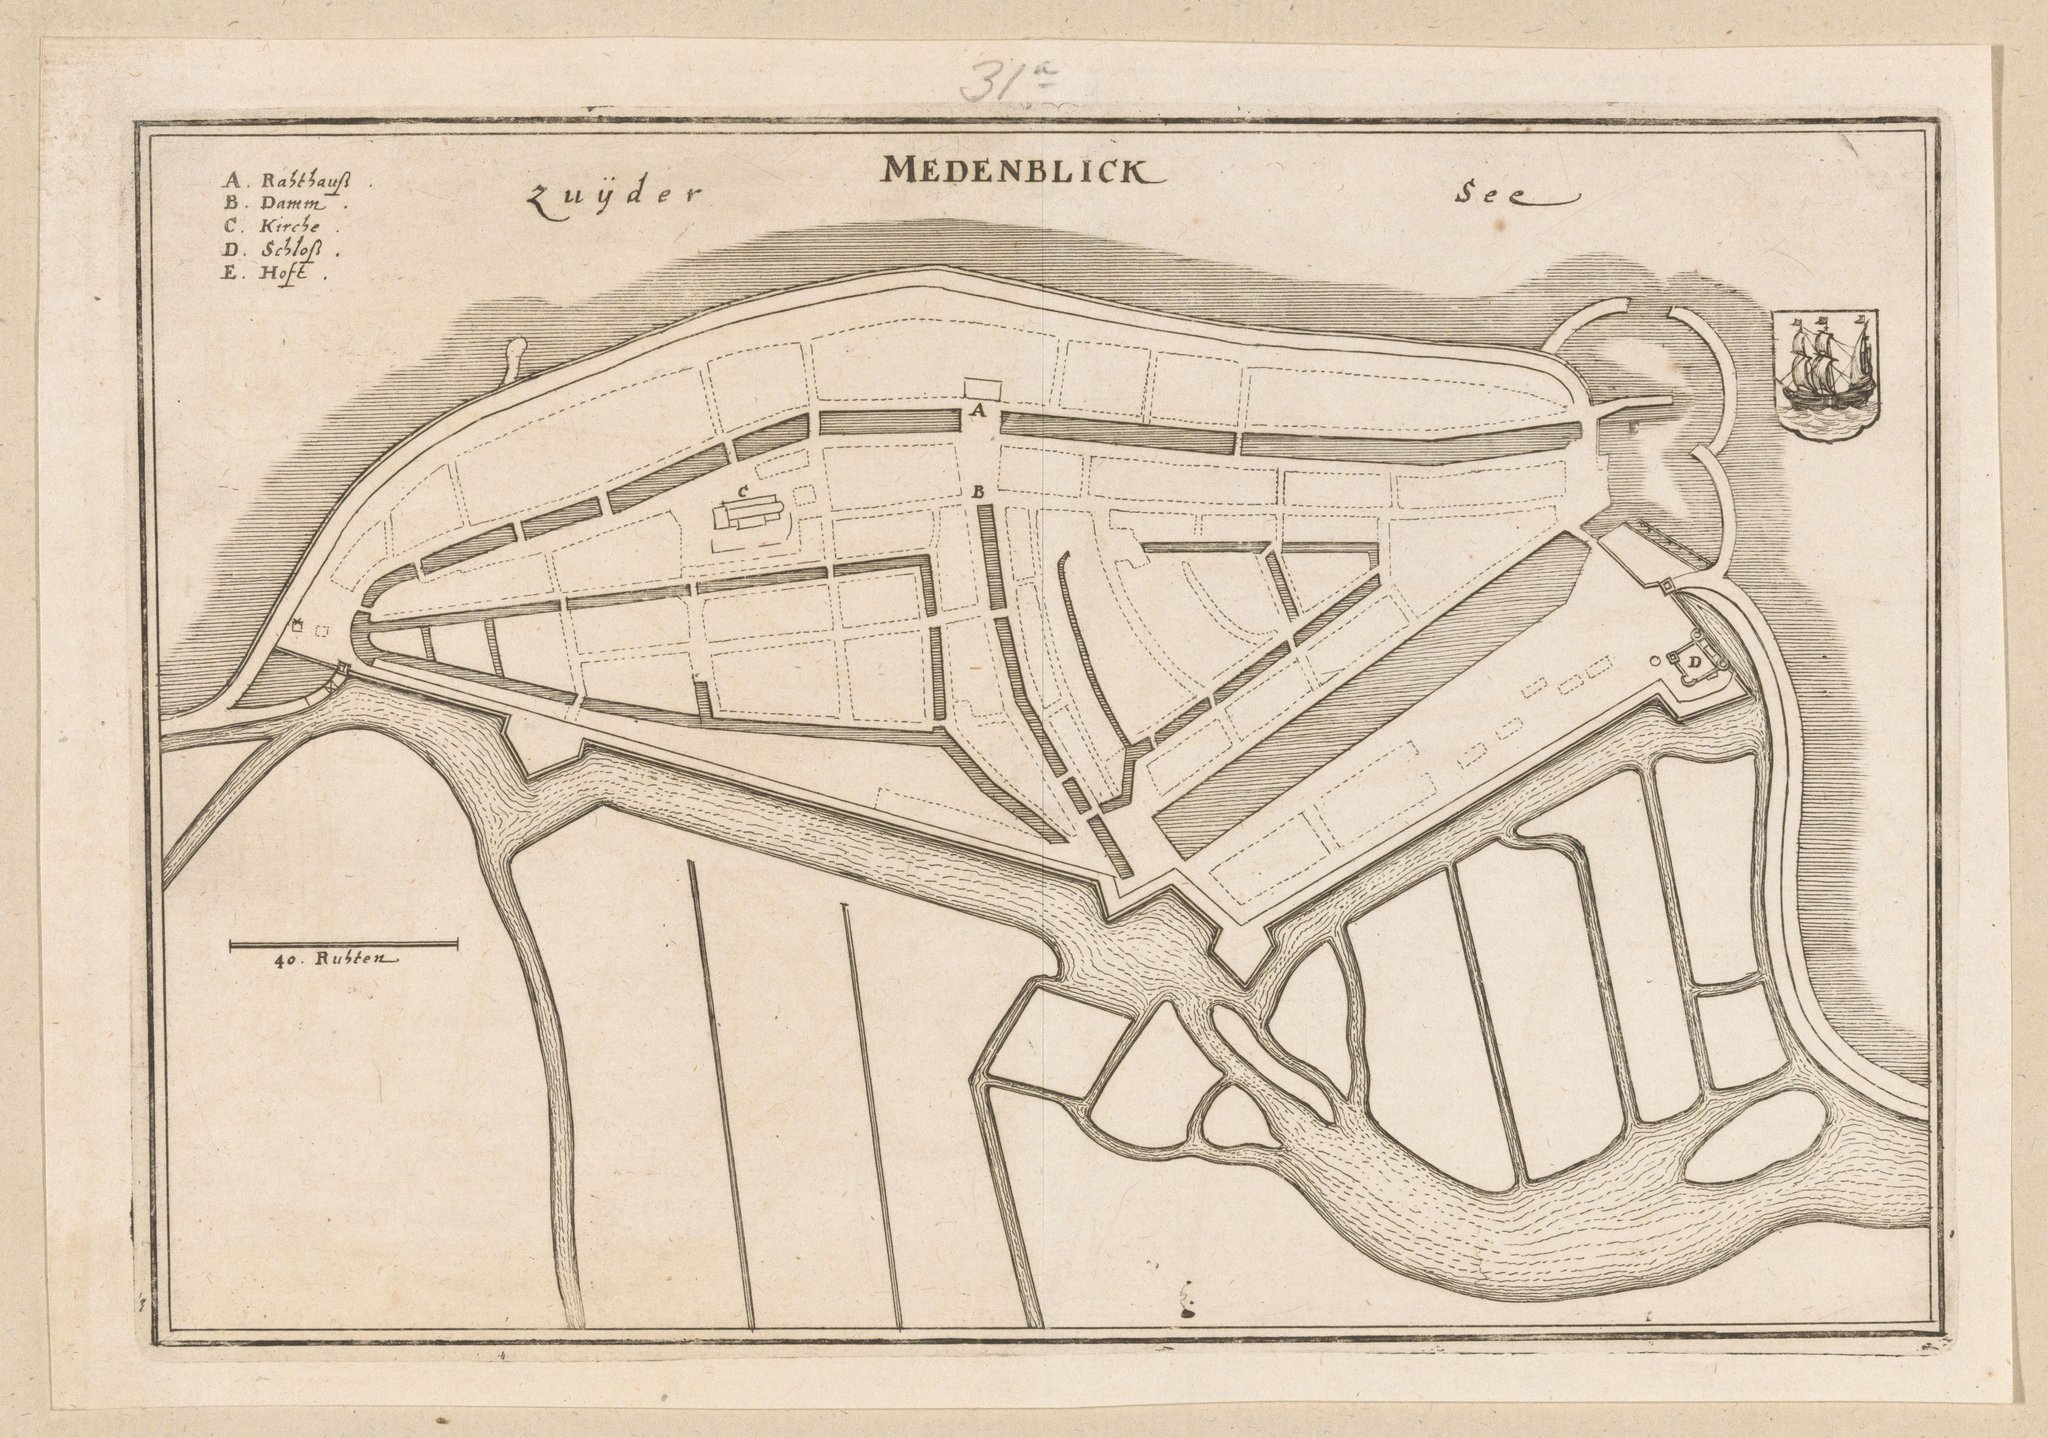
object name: print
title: Medenblick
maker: caspar merian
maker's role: print maker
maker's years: 1627-1689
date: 1654-1700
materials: paper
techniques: engraving, etching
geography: frankfurt am main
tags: coat of arms (as symbol of the state, etc.) (+ city; municipal), fortified city, maps of cities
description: Prent gebruikt in: Zeiller, Martin. M.Z. Topographia Circuli Burgundici Oder Beschreibung une Eigentliche Abbildung der Vornehmsten Örter in dem Hochlöblichen Burgund- un Niderlandischen Crayse. Frankfurt am Main: Caspar Merian, 1654. Of in: Zeiller, Martin. M. Z. Topographia Germaniae-Inferioris vel Circuli-Burgundici, das ist Beschreibung (…). Frankfurt am Main: Caspar Merian, 1659. Of in een van de twee latere uitgaven van deze publicatie die, hoewel het jaar 1659 erin staat vermeld als jaar van uitgave, zijn uitgegeven in respectievelijk ca. 1670 en ca. 1700.